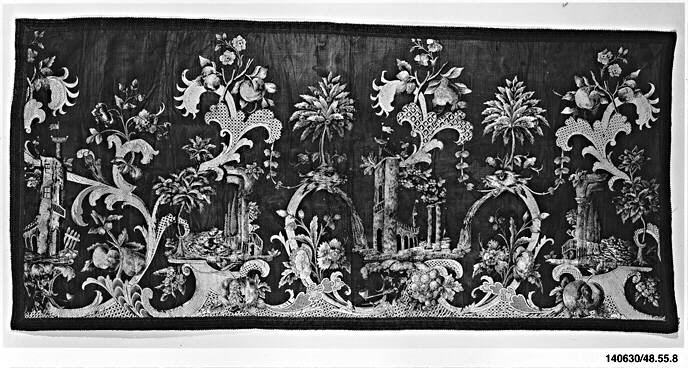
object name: panel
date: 1726-1750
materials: silk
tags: leaves